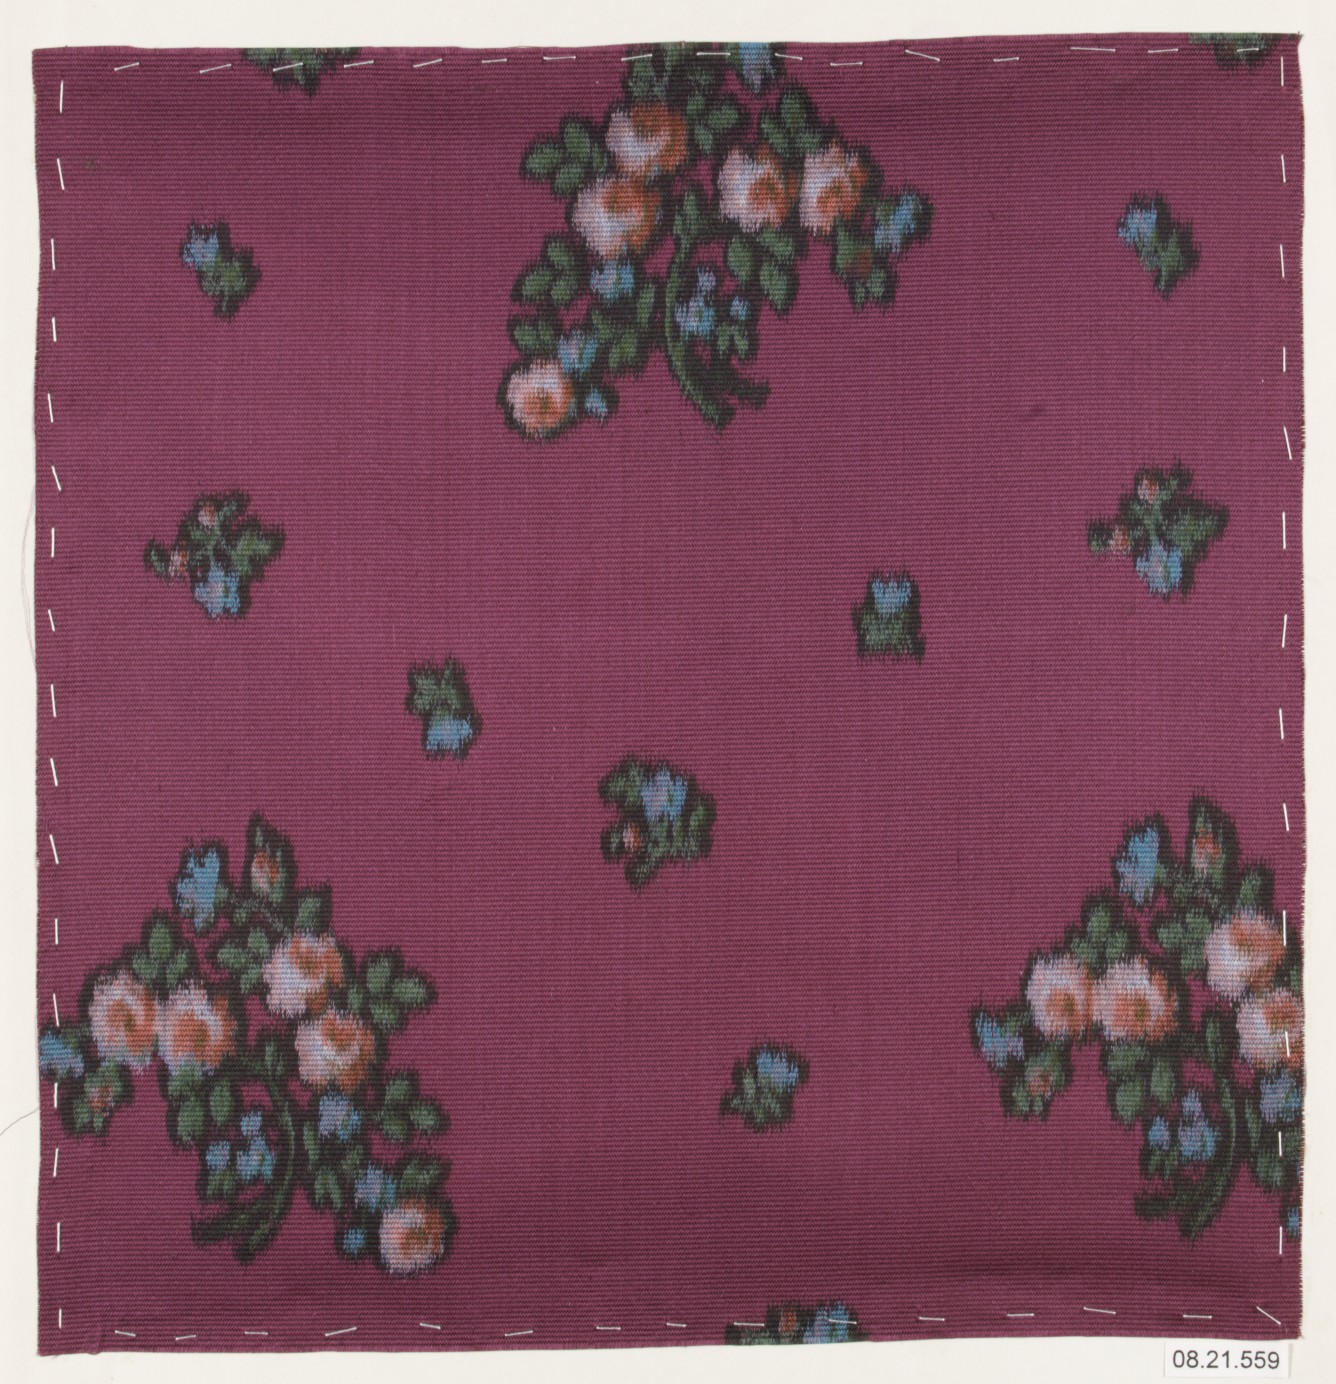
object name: textile sample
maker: Anonymous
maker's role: designer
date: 1900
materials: silk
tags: flowers